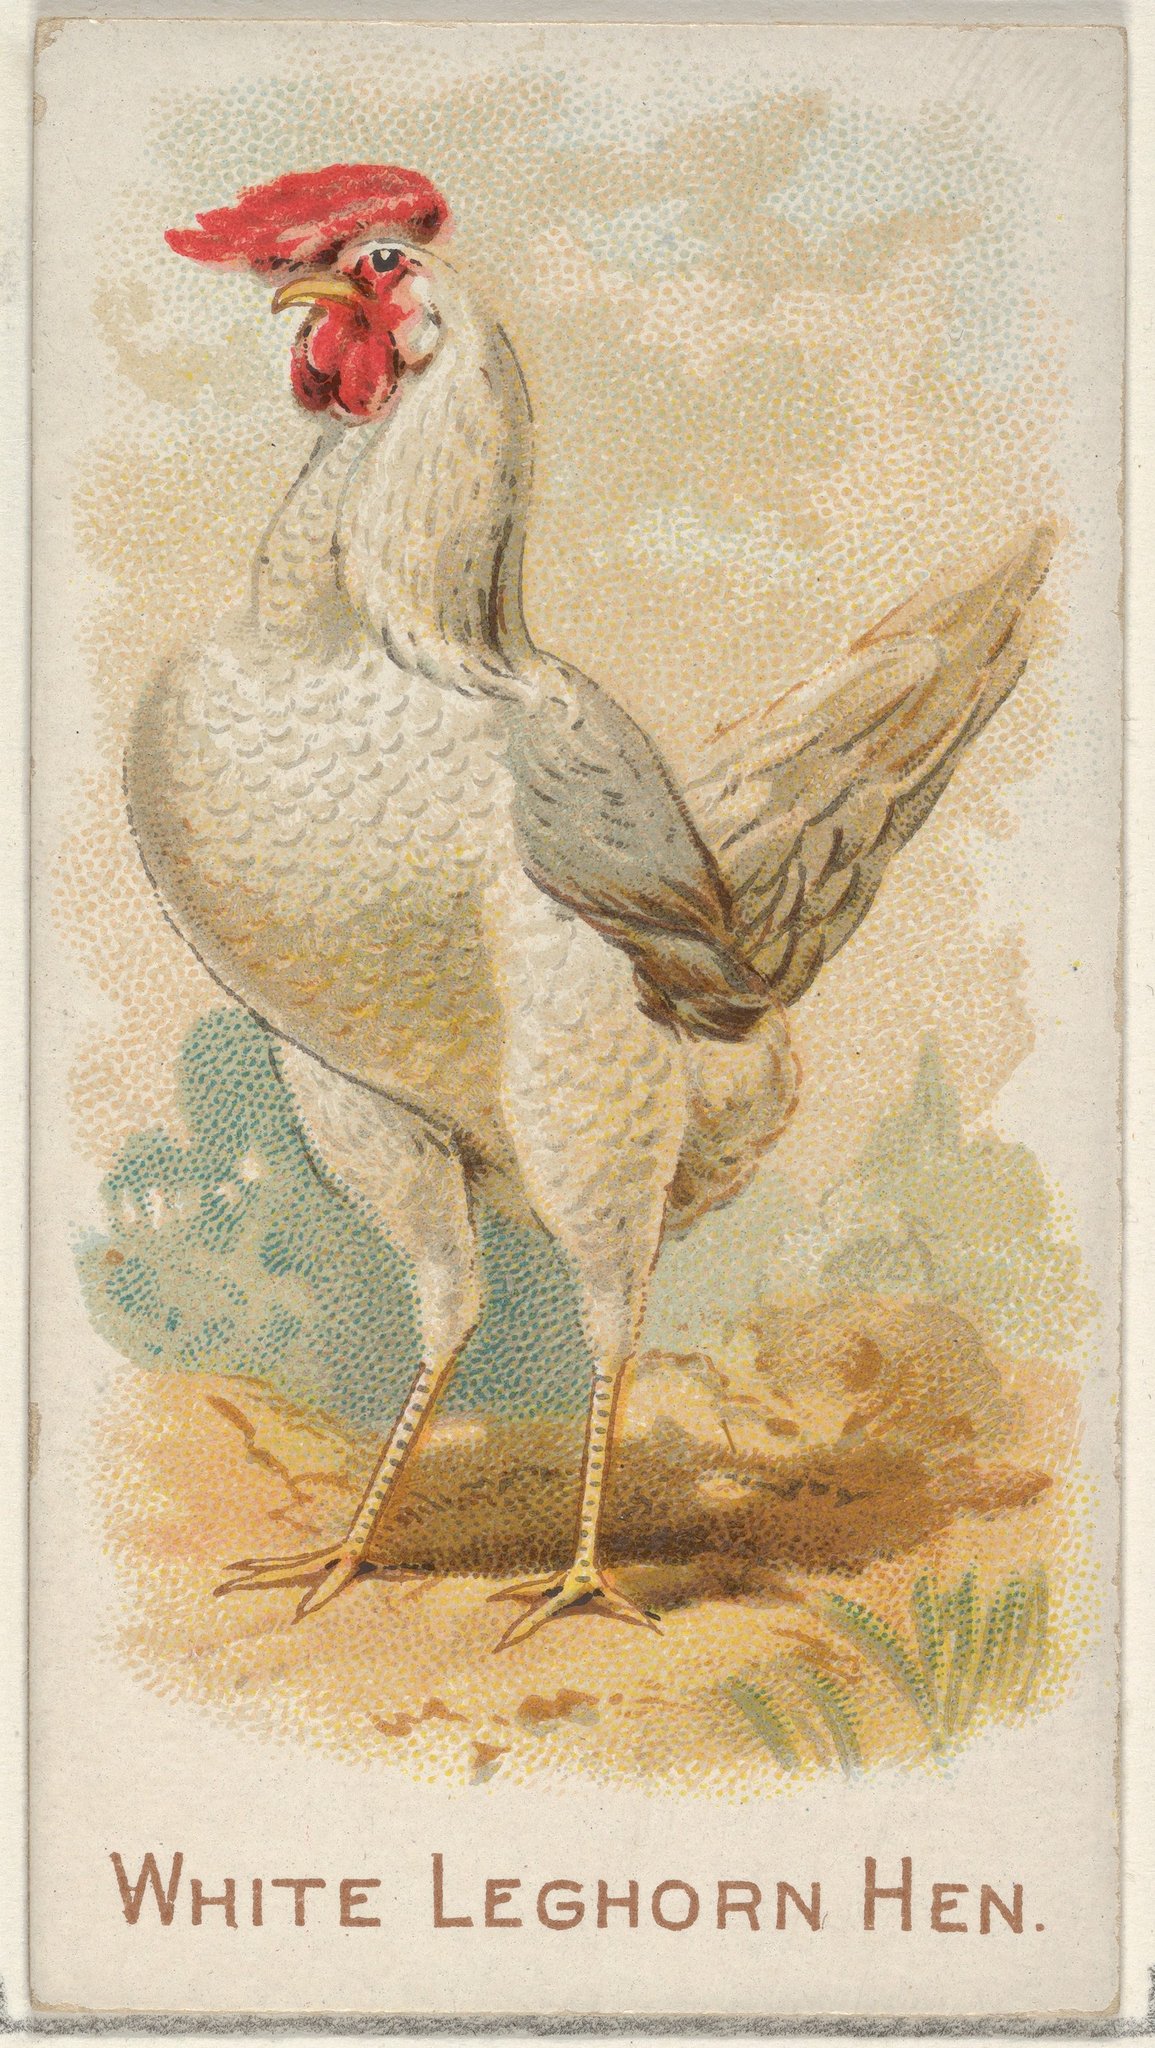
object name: print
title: White Leghorn Hen, from the Prize and Game Chickens series (N20) for Allen & Ginter Cigarettes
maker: allen & ginter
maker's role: publisher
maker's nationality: american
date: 1891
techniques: color lithograph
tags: chickens